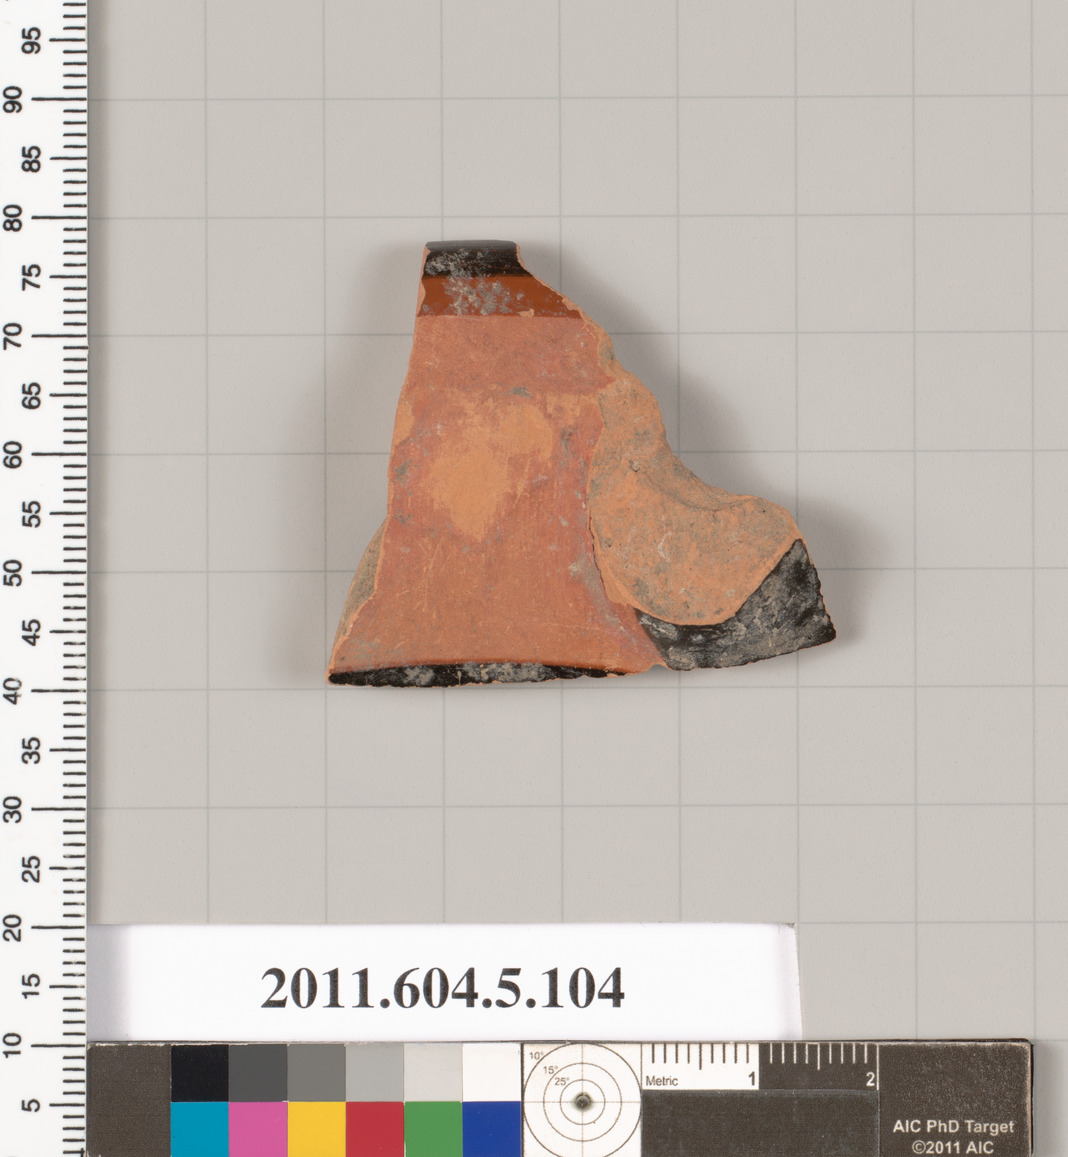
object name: kylix fragment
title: Terracotta rim fragment of a stemless kylix(drinking cup)?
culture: greek, attic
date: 470-450 BCE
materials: terracotta